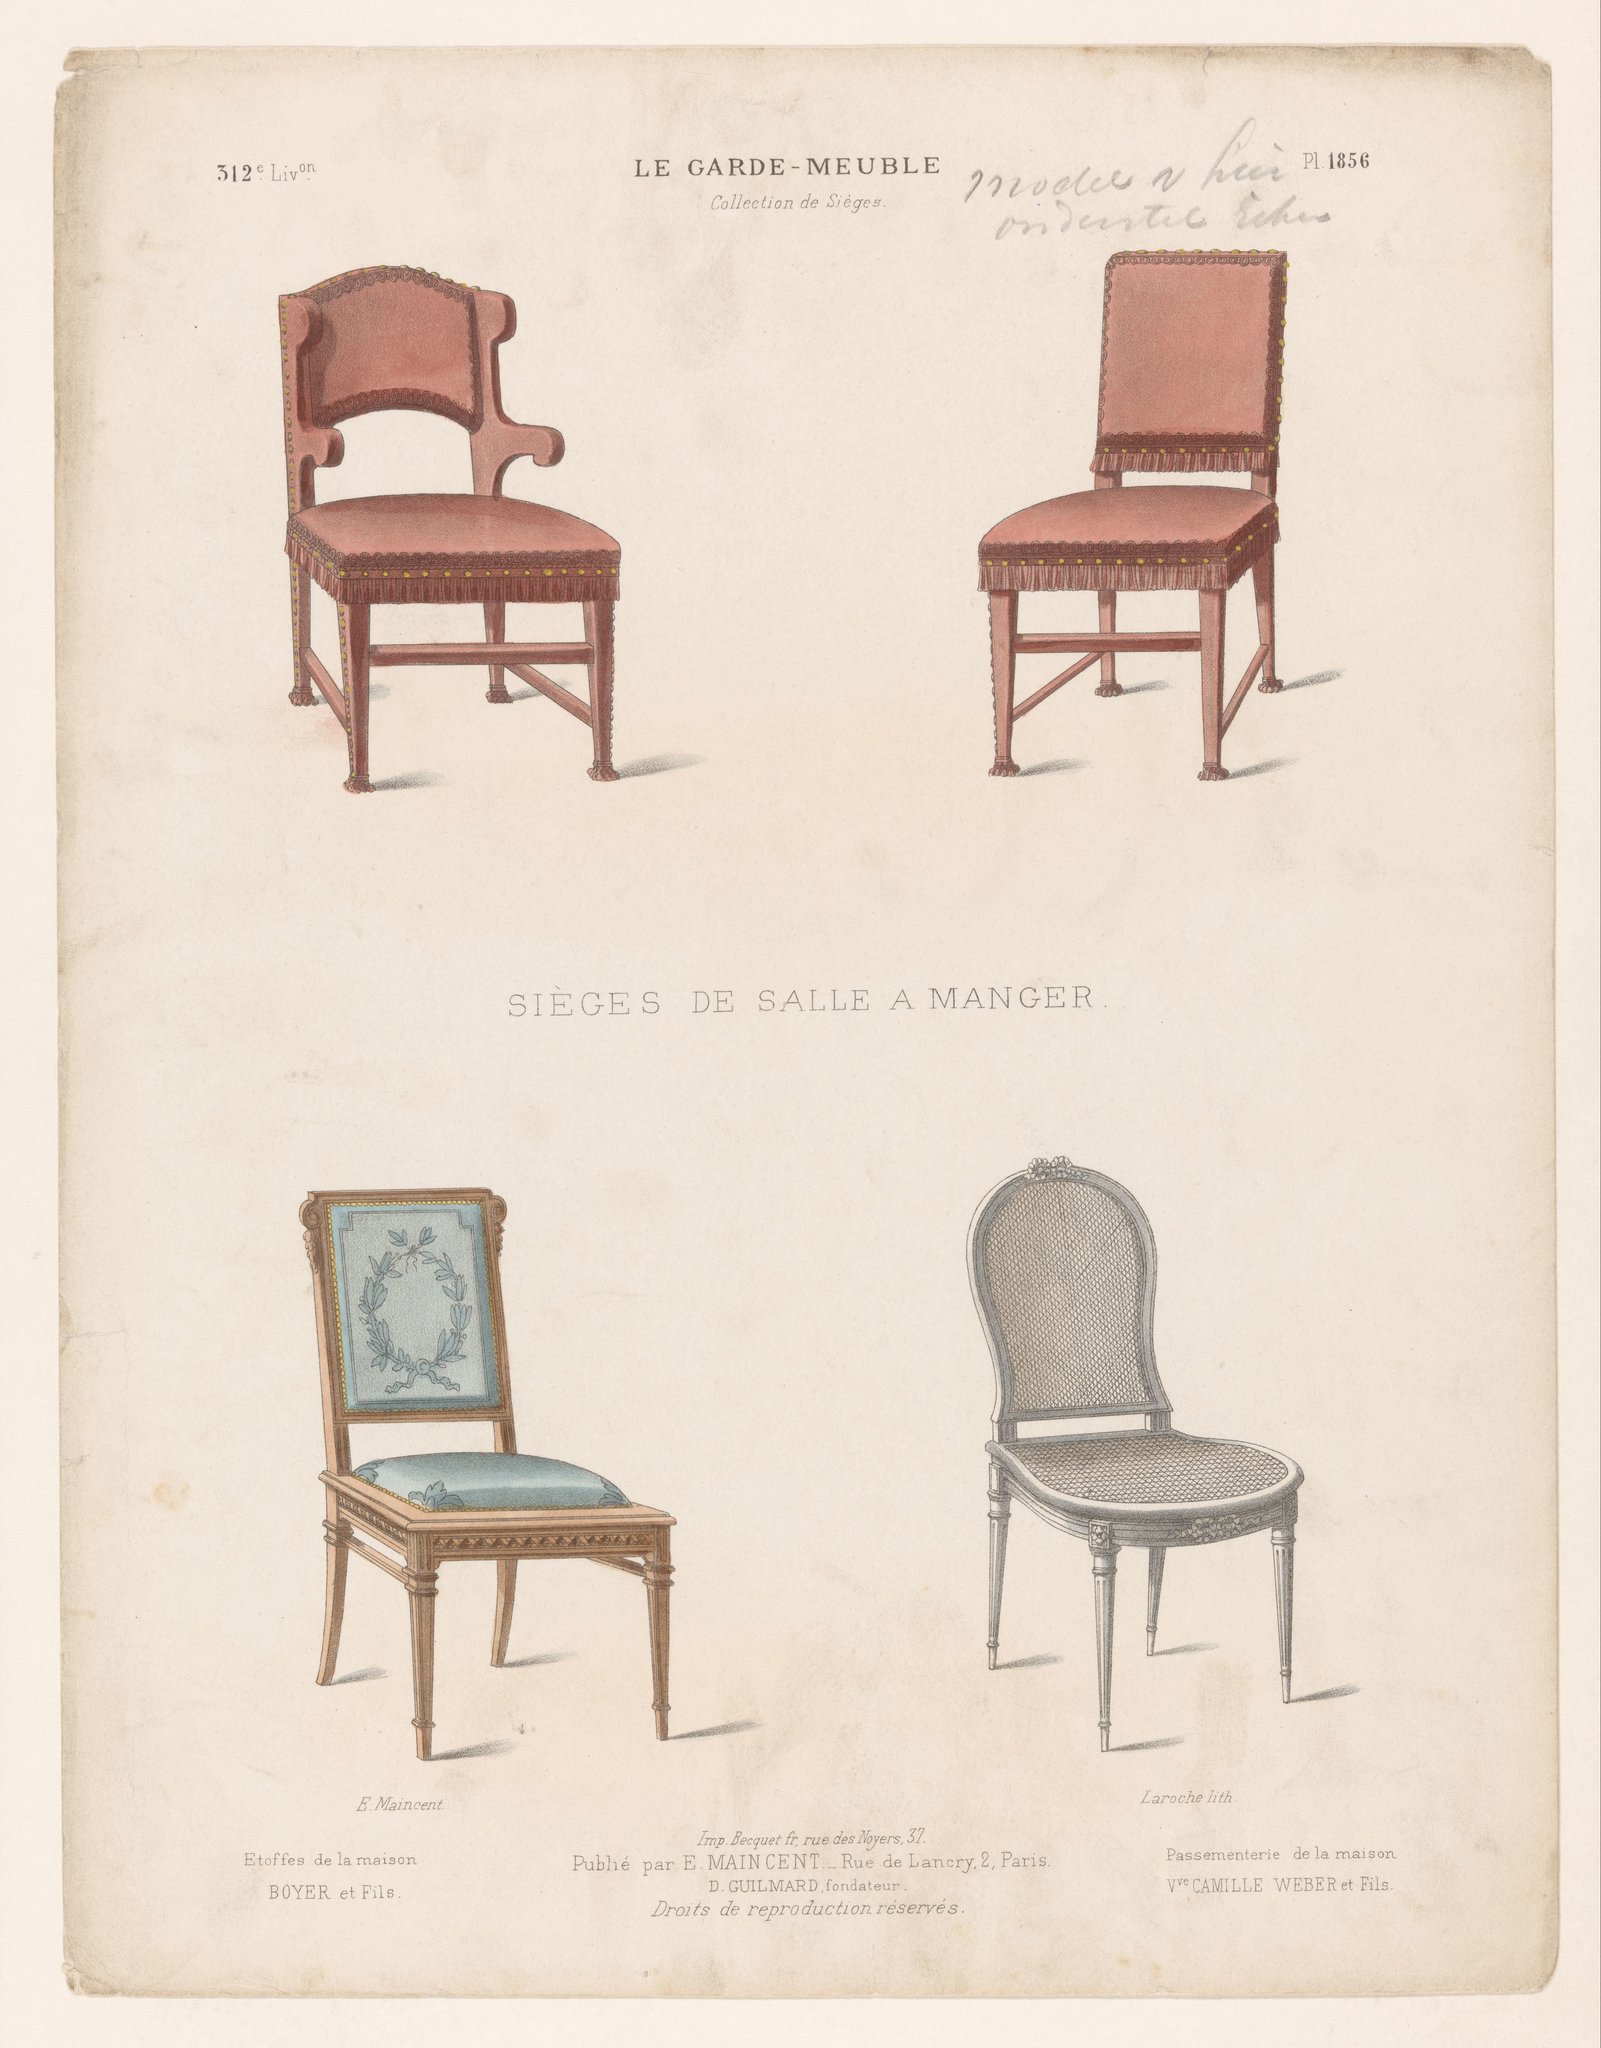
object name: print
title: Sièges de salle a manger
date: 1885-1895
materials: paper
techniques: hand coloring, lithograph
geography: paris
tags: seating furniture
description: Ieder Livraison in de serie Le Garde-Meuble bevat negen platen: drie 'sièges' (zitmeubels), drie 'meubles' (diverse meubels zoals tafels en kasten) en drie 'tentures' (gordijnen en draperieën).